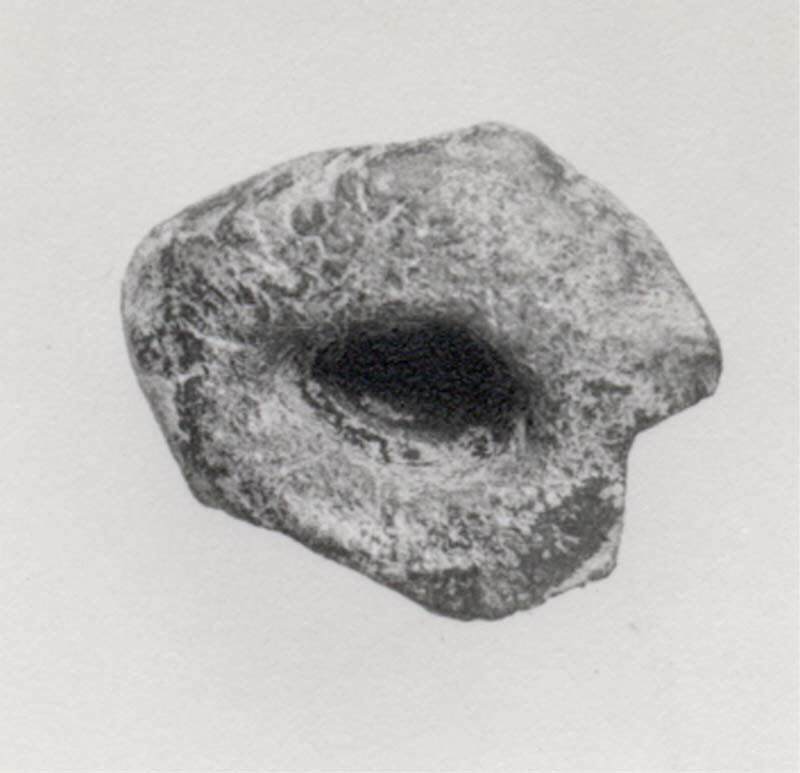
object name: sealing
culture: sasanian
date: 601-700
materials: clay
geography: iran